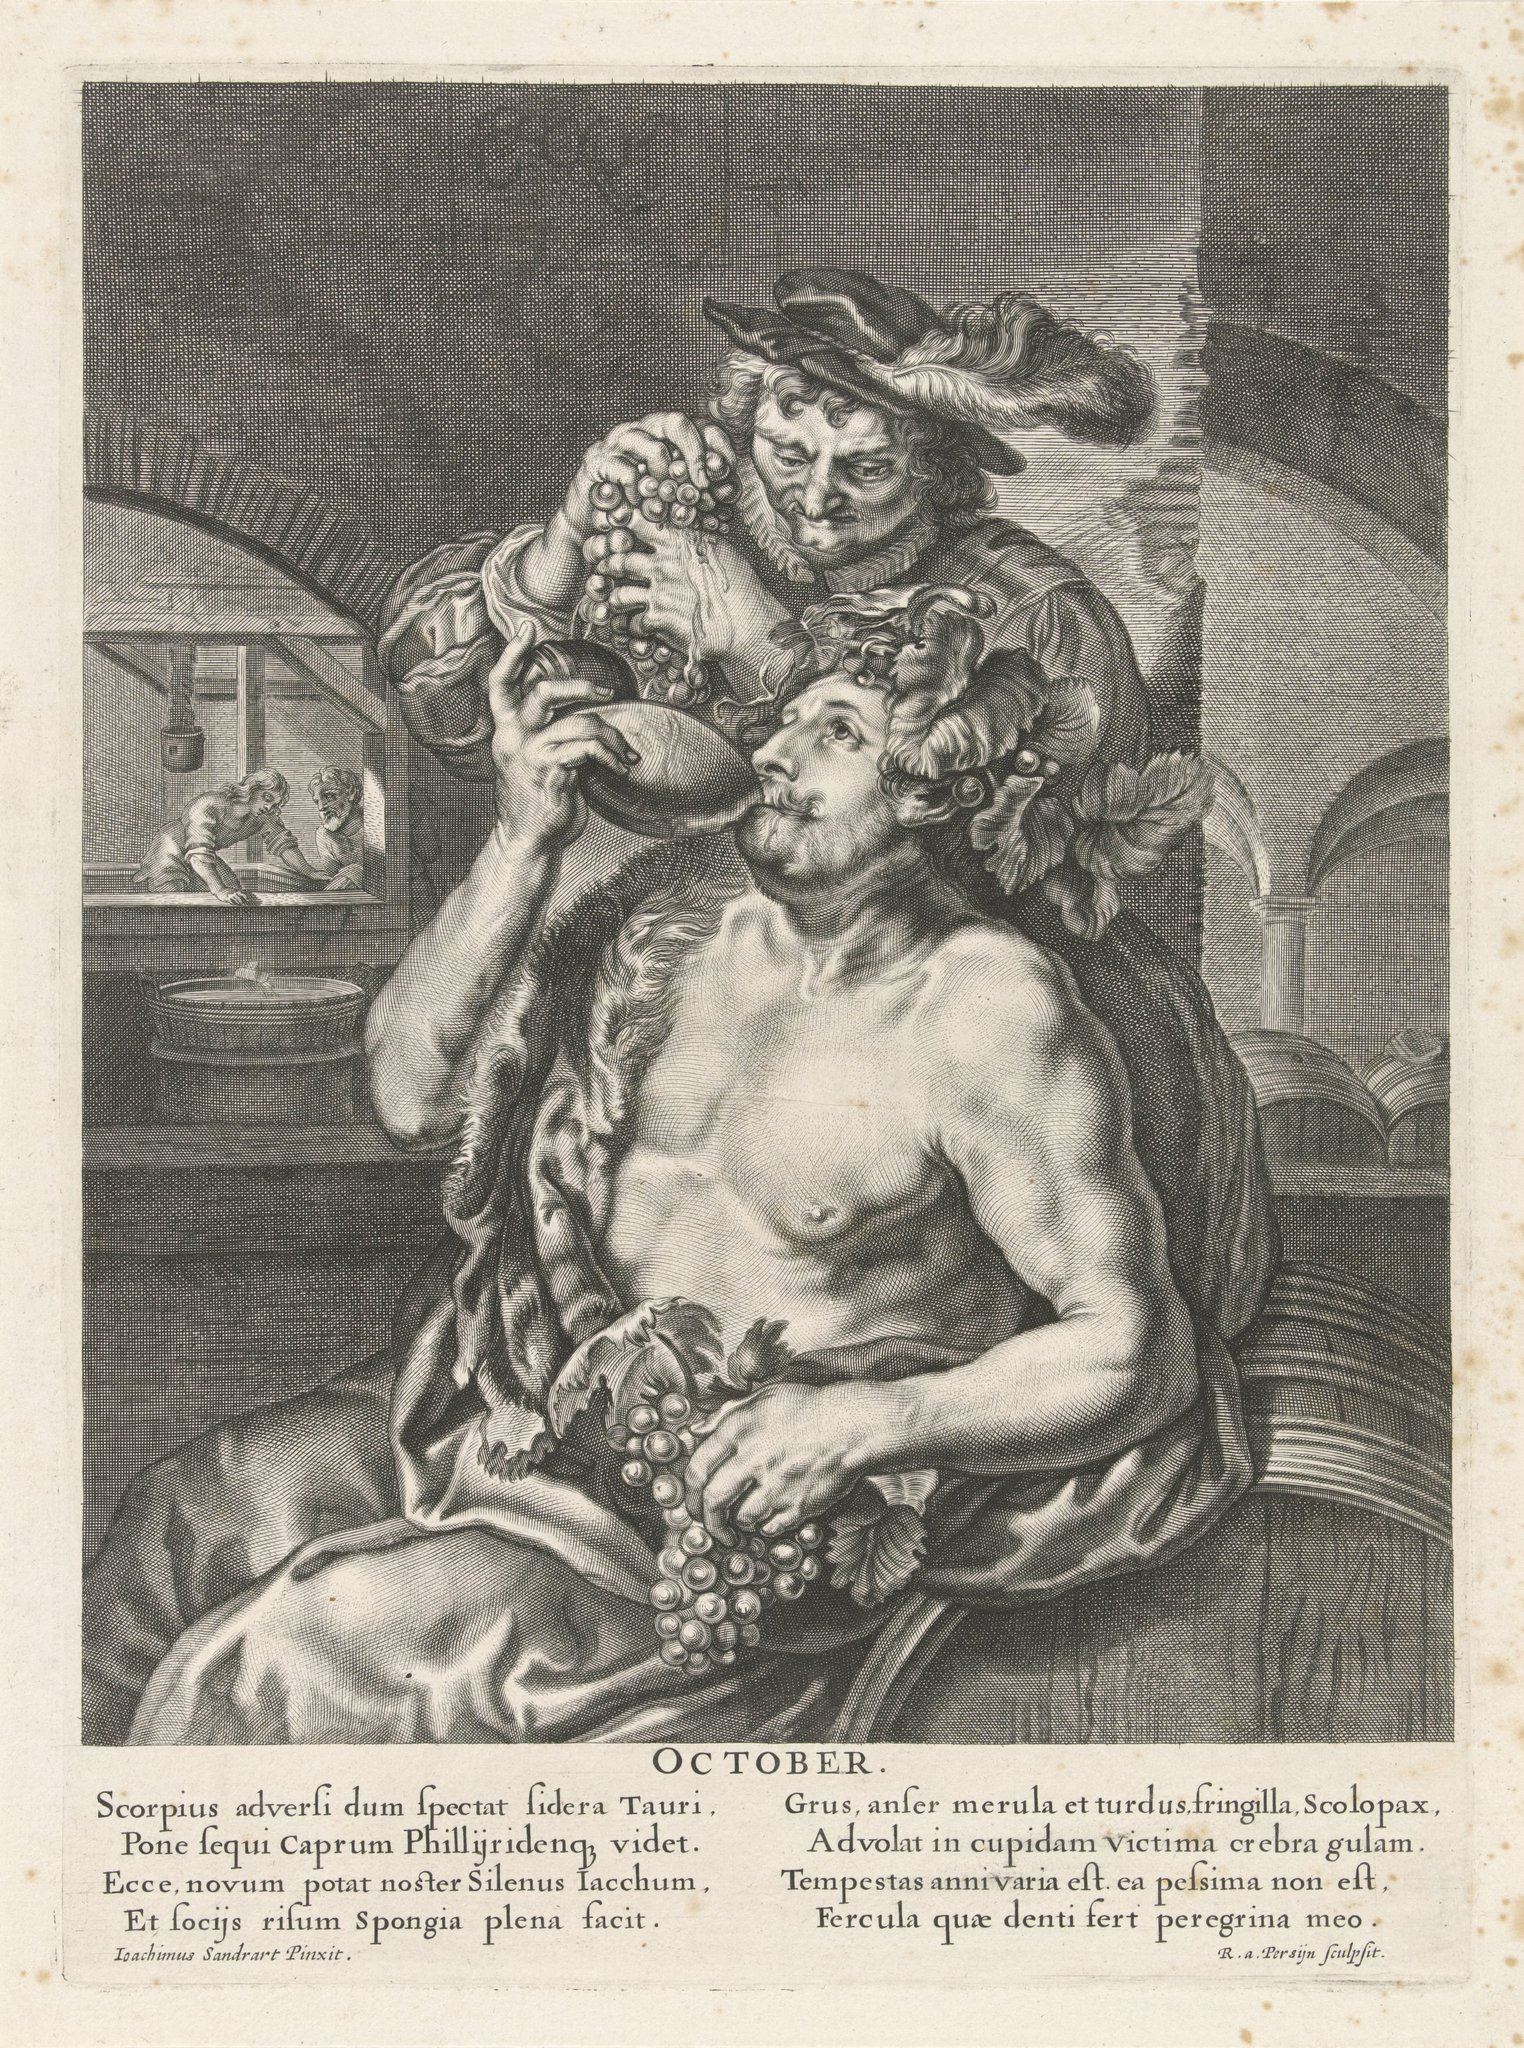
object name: print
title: Oktober: Bacchus die wijn drinkt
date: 1645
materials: paper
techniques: engraving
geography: gouda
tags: pressing grapes, october and its 'labours' (+ with zodiacal signs)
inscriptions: collector's mark: Lugt 240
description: Joachim van Sandrart gaf de prenten naar zijn schilderijen van de twaalf maanden, de dag en de nacht, zelf uit in 1645. Zij werden vervaardigd door verschillende graveurs: Theodor Matham, Reinier van Persijn, Jonas Suyderhoef, Jeremias Falck, Cornelis van Dalen (II) en Albert Haelwegh.